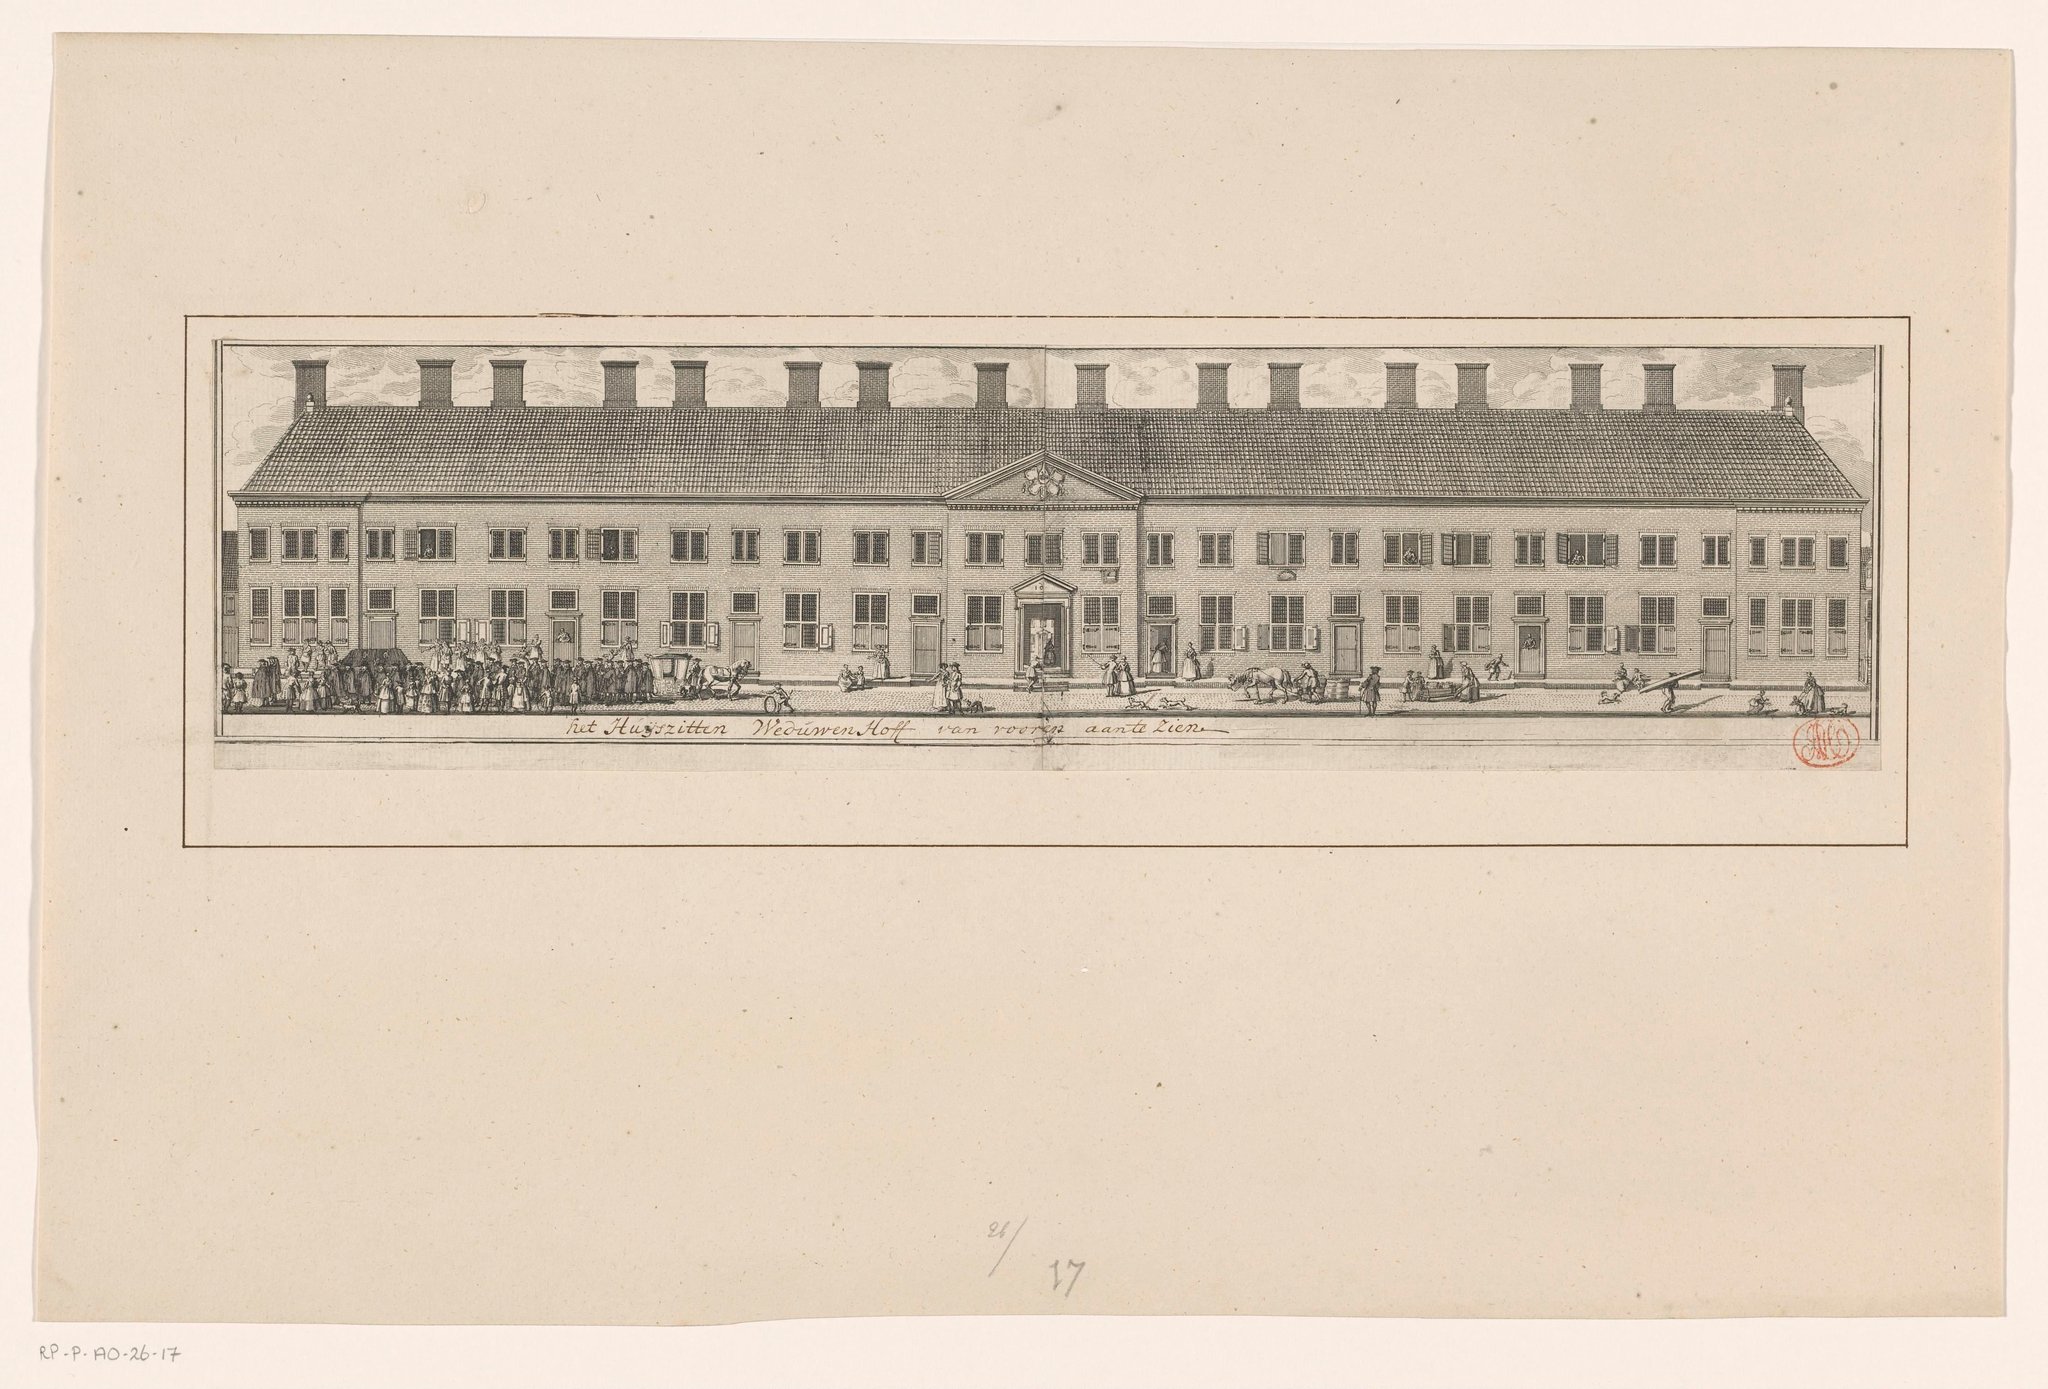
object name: print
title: Het Huijszitten Weduwenhoff van vooren aante zien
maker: adolf van der laan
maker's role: draughtsman, print maker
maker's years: 1689-1742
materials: ink, paper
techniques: etching, pen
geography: amsterdam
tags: public welfare, poorhouse, cortege, funeral procession, old-people's home, street (+ city(-scape) with figures, staffage)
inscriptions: collector's mark: Lugt 195, inscription: ‘Het Huijszitten Weduwenhoff van vooren aante zien’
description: Afgesneden van een proefdruk van één van de twee platen van de prent 'Platte gronden van het Oude Zyds Huiszitten Huis en Huiszitten Weduwen Hof, beneven deszelfs opstallen'. Deze prent bestaat uit plattegronden van het Oudezijds Huiszittenhuis en het Huiszitten Weduwenhof (Kartuizerhof), met daaromheen allegorische voorstellingen, wapenschilden en gezichten op verschillende delen van beide gebouwen. Huidige object is afgesneden van een poefdruk van zowel de linker- als de rechterplaat. Zie ook RP-P-AO-26-9-1, RP-P-AO-26-9-2, RP-P-AO-26-10, RP-P-AO-26-11-1, RP-P-AO-26-11-2 en RP-P-AO-26-18.